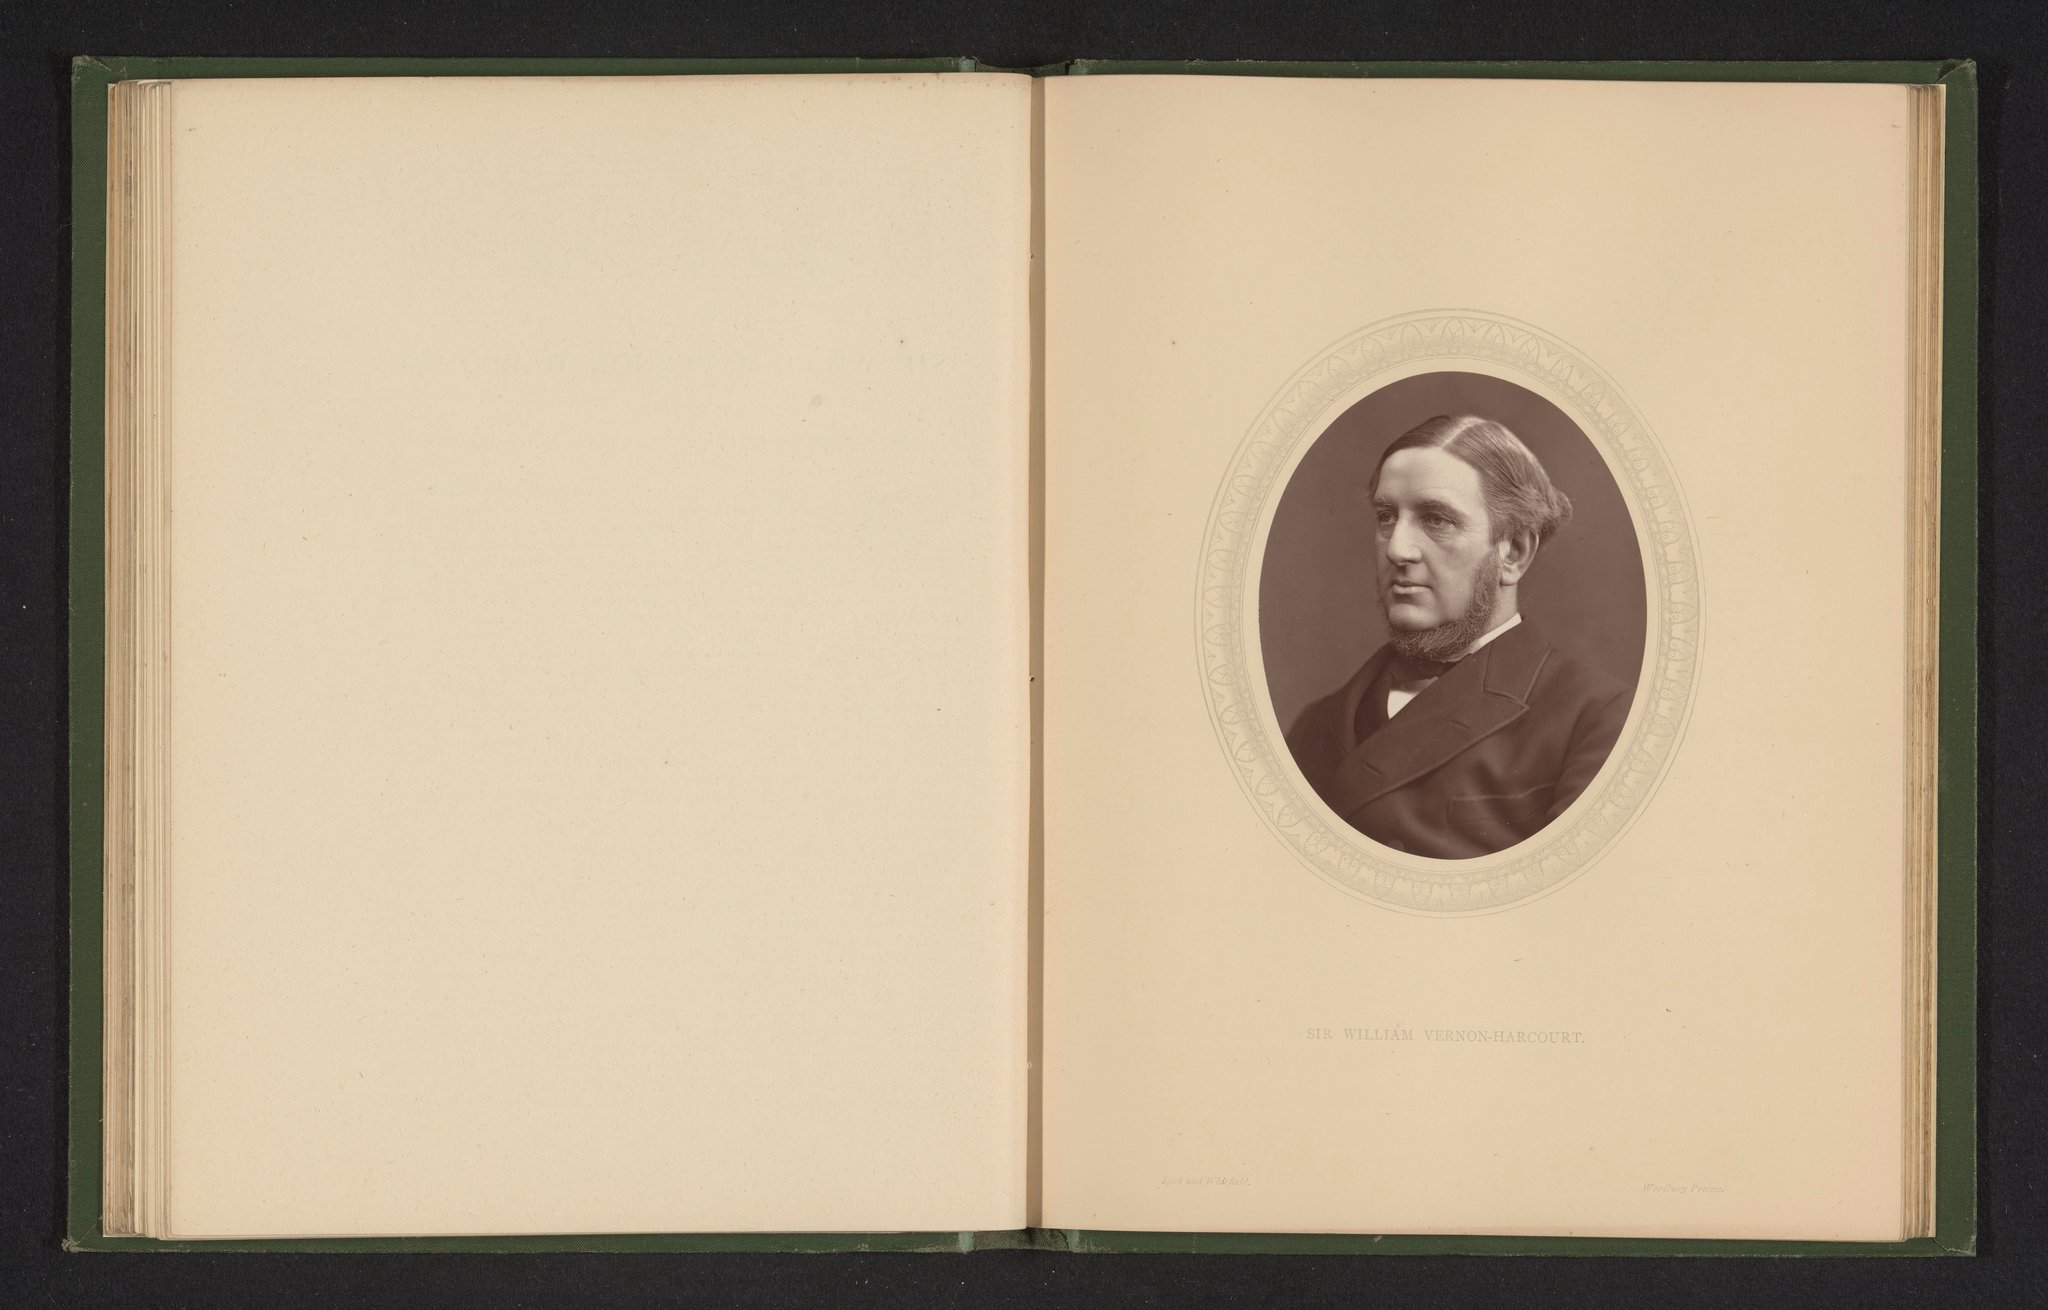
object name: page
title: Sir William Vernon-Harcourt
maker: Anonymous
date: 1872-1877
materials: paper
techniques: woodburytype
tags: lawyer, attorney at law, historical persons (portraits and scenes from the life) (+ (full) bust portrait)